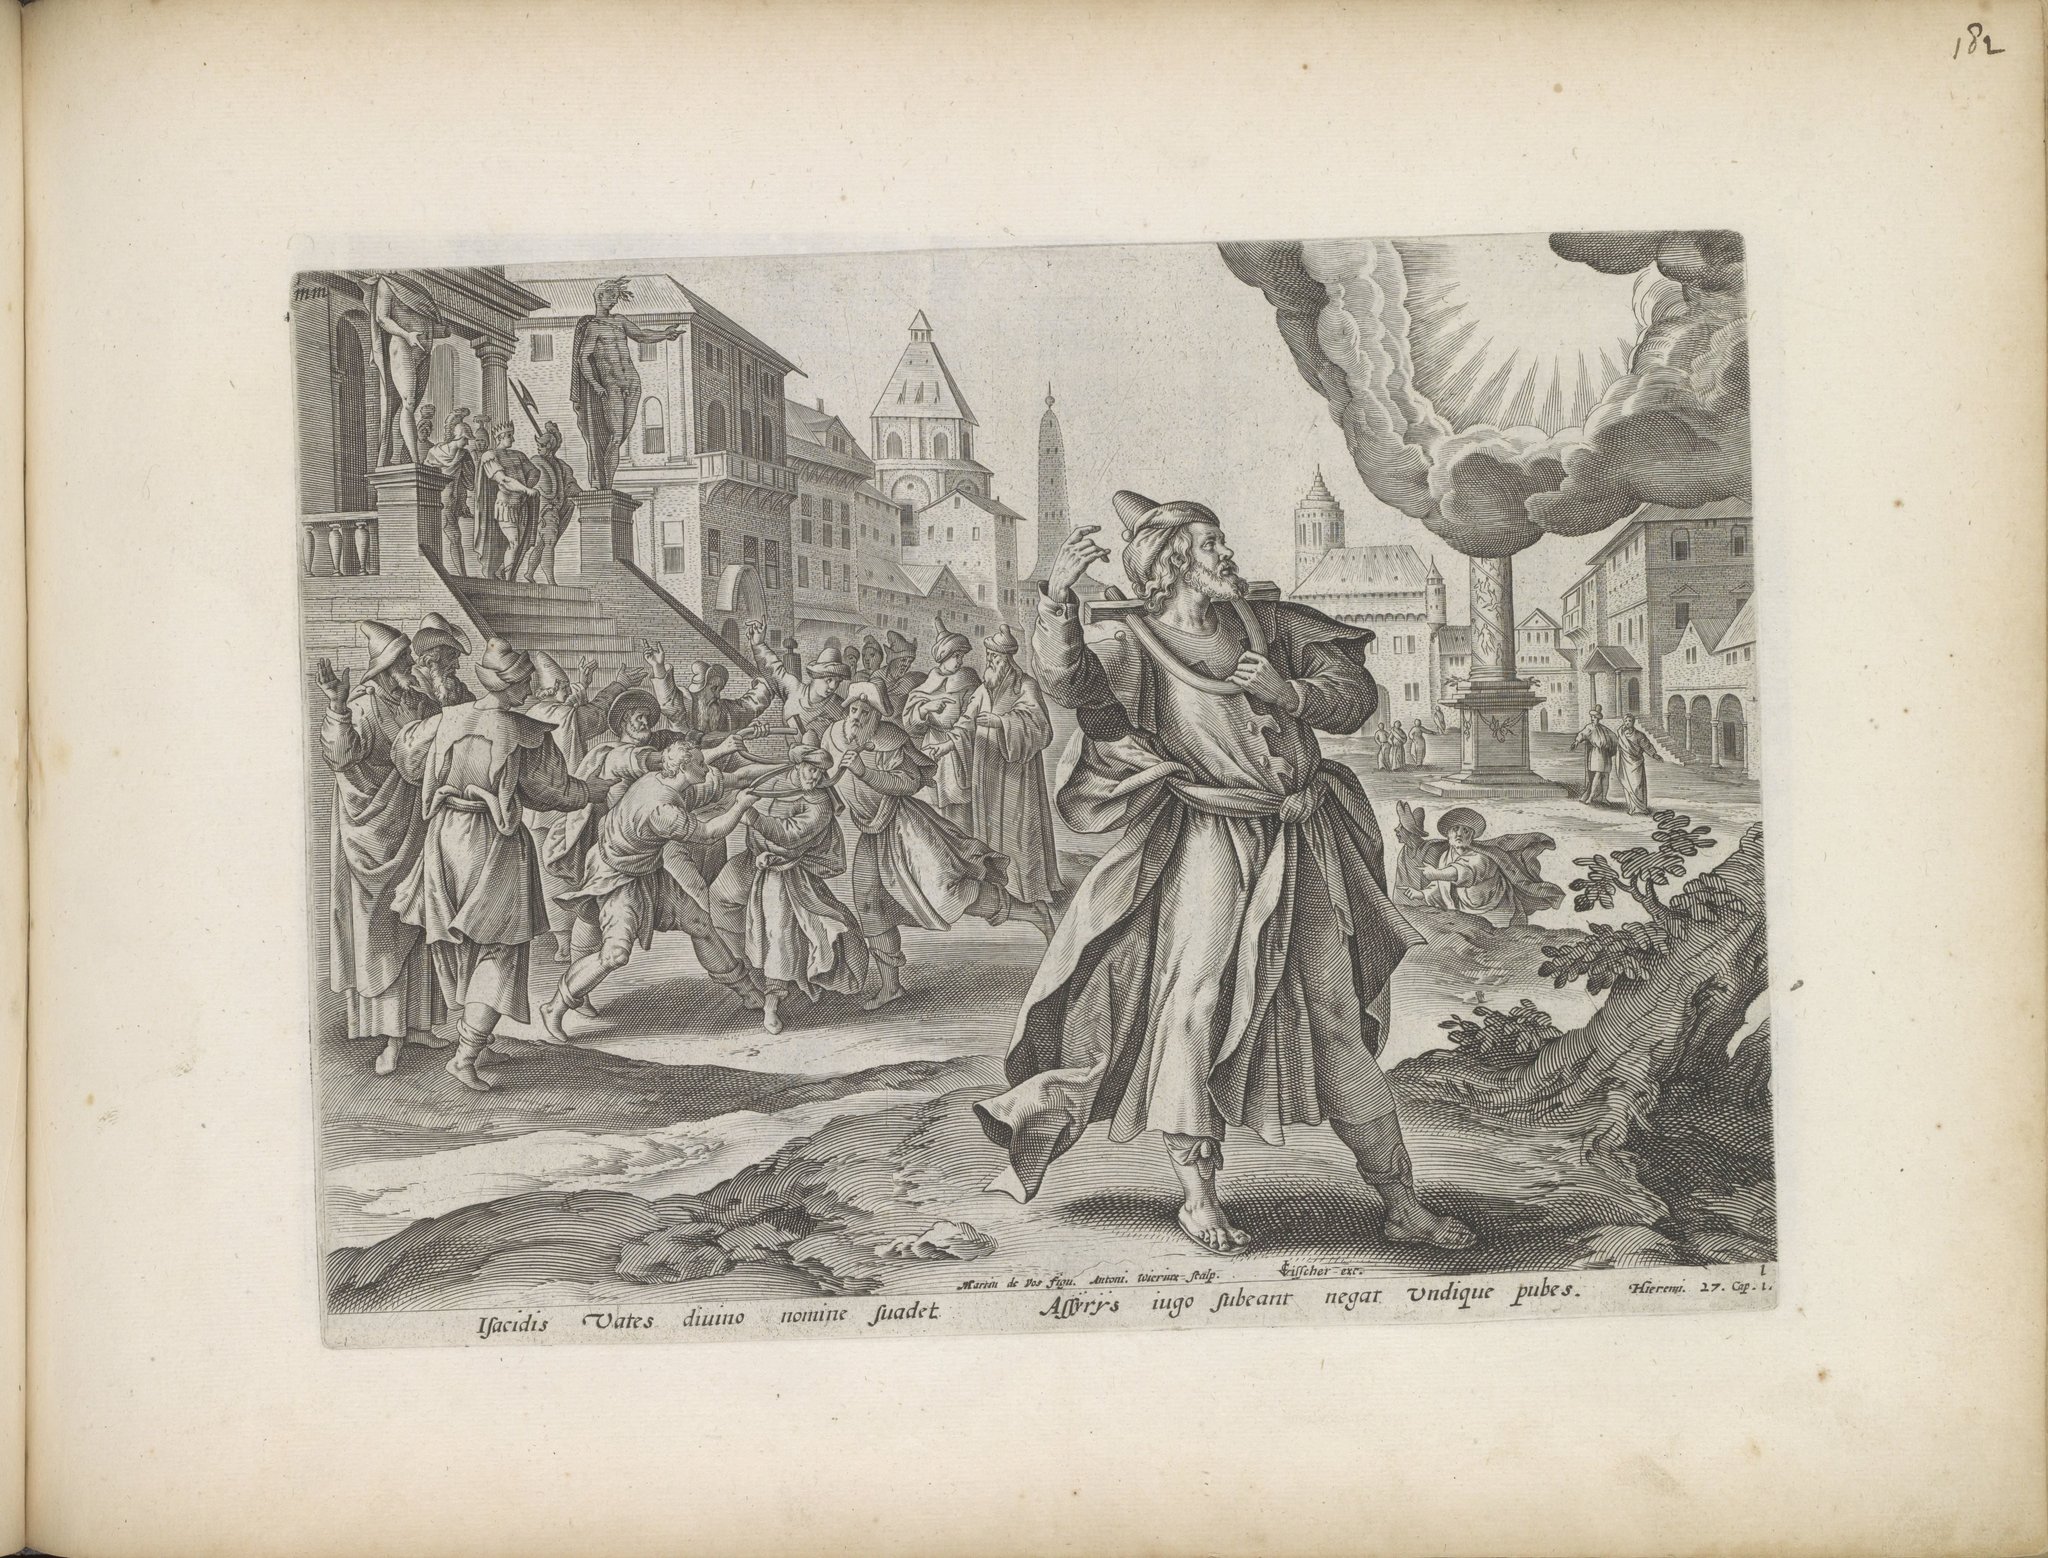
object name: album leaf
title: God verschijnt aan Jeremia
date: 1585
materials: paper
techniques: engraving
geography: amsterdam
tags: jeremiah communicating with god, jeremiah appears before king zedekiah with a wooden yoke (jeremiah 27-28), hananiah prophesies falsely in the temple and breaks jeremiah's wooden yoke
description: God verschijnt als een stralenkrans aan de hemel. De profeet Jeremia staat met zijn hand opgeheven en kijkt omhoog met om zijn nek een juk dat God hem heeft opgedragen te maken als symbool voor het juk van Babylonië. Links koning Sedekia van Juda op een verhoging. Onderaan de trap breekt de profeet Chananja met behulp van anderen het juk om de nek van Jeremia in stukken. Onder de voorstelling een verwijzing in het Latijn naar de Bijbeltekst in Jer. 27:1. Deze prent maakt deel uit van een album.